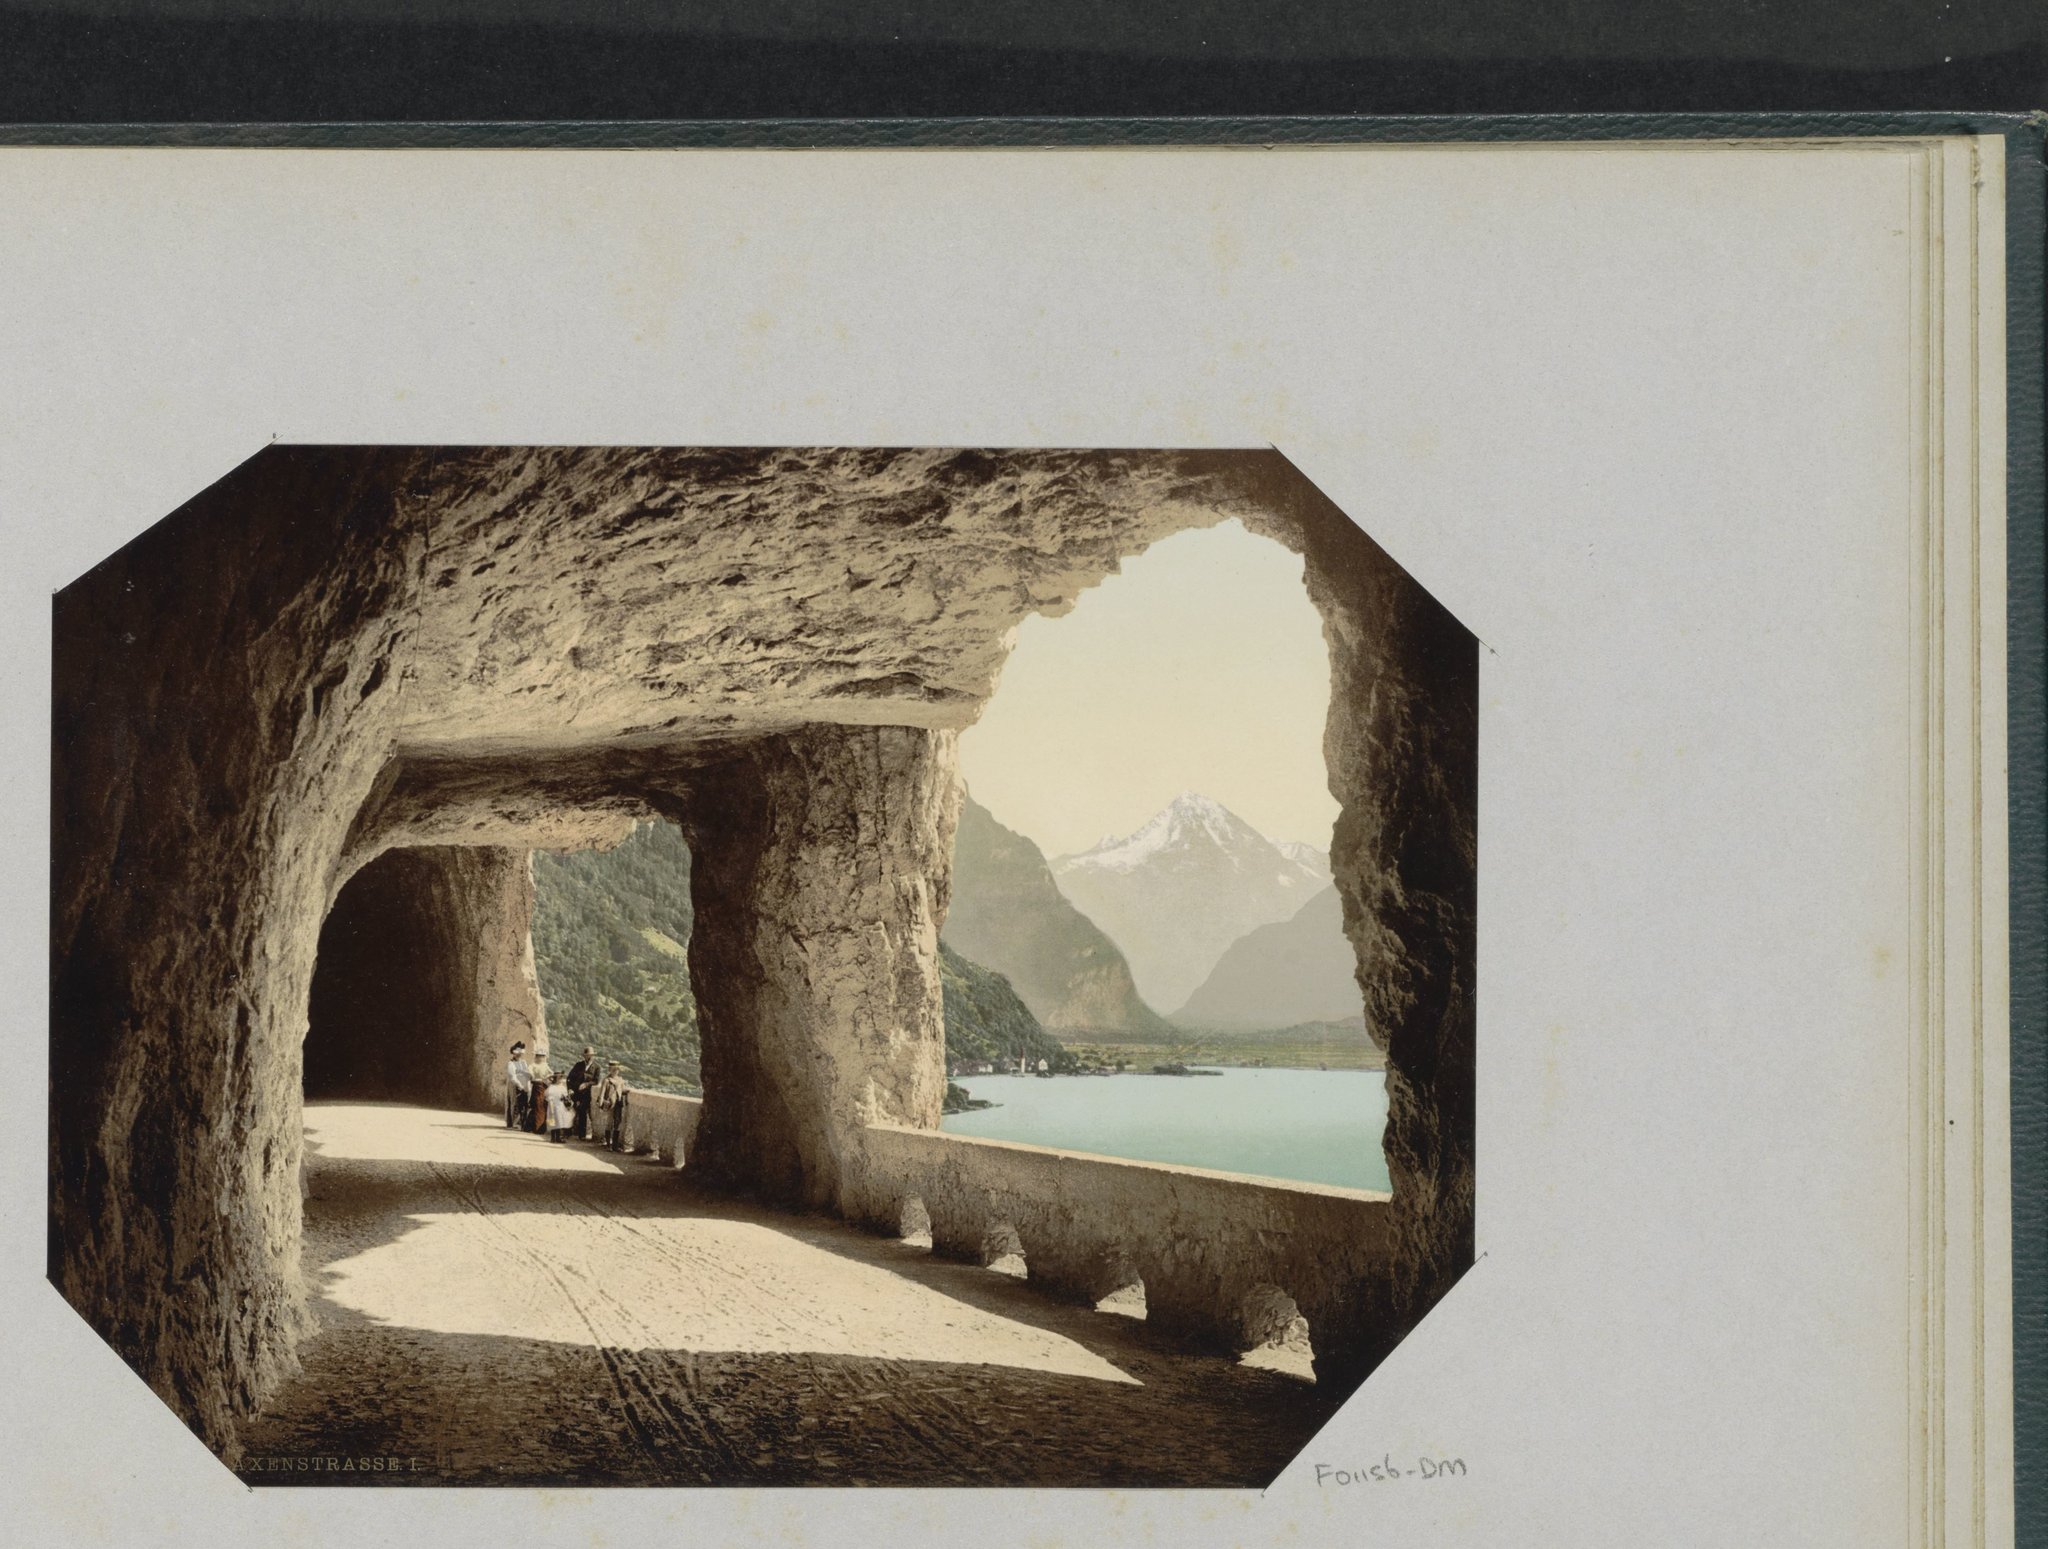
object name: photomechanical print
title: Tunnel op de Axenstrasse te Zwitserland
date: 1896-1897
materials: paper, photographic process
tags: underground road, tunnel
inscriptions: inscription: ‘1150. P.Z. - Axenstrasse I.’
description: Deze prent maakt deel uit van een album.